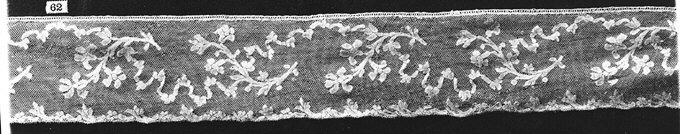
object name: fragment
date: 1701-1800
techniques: lace